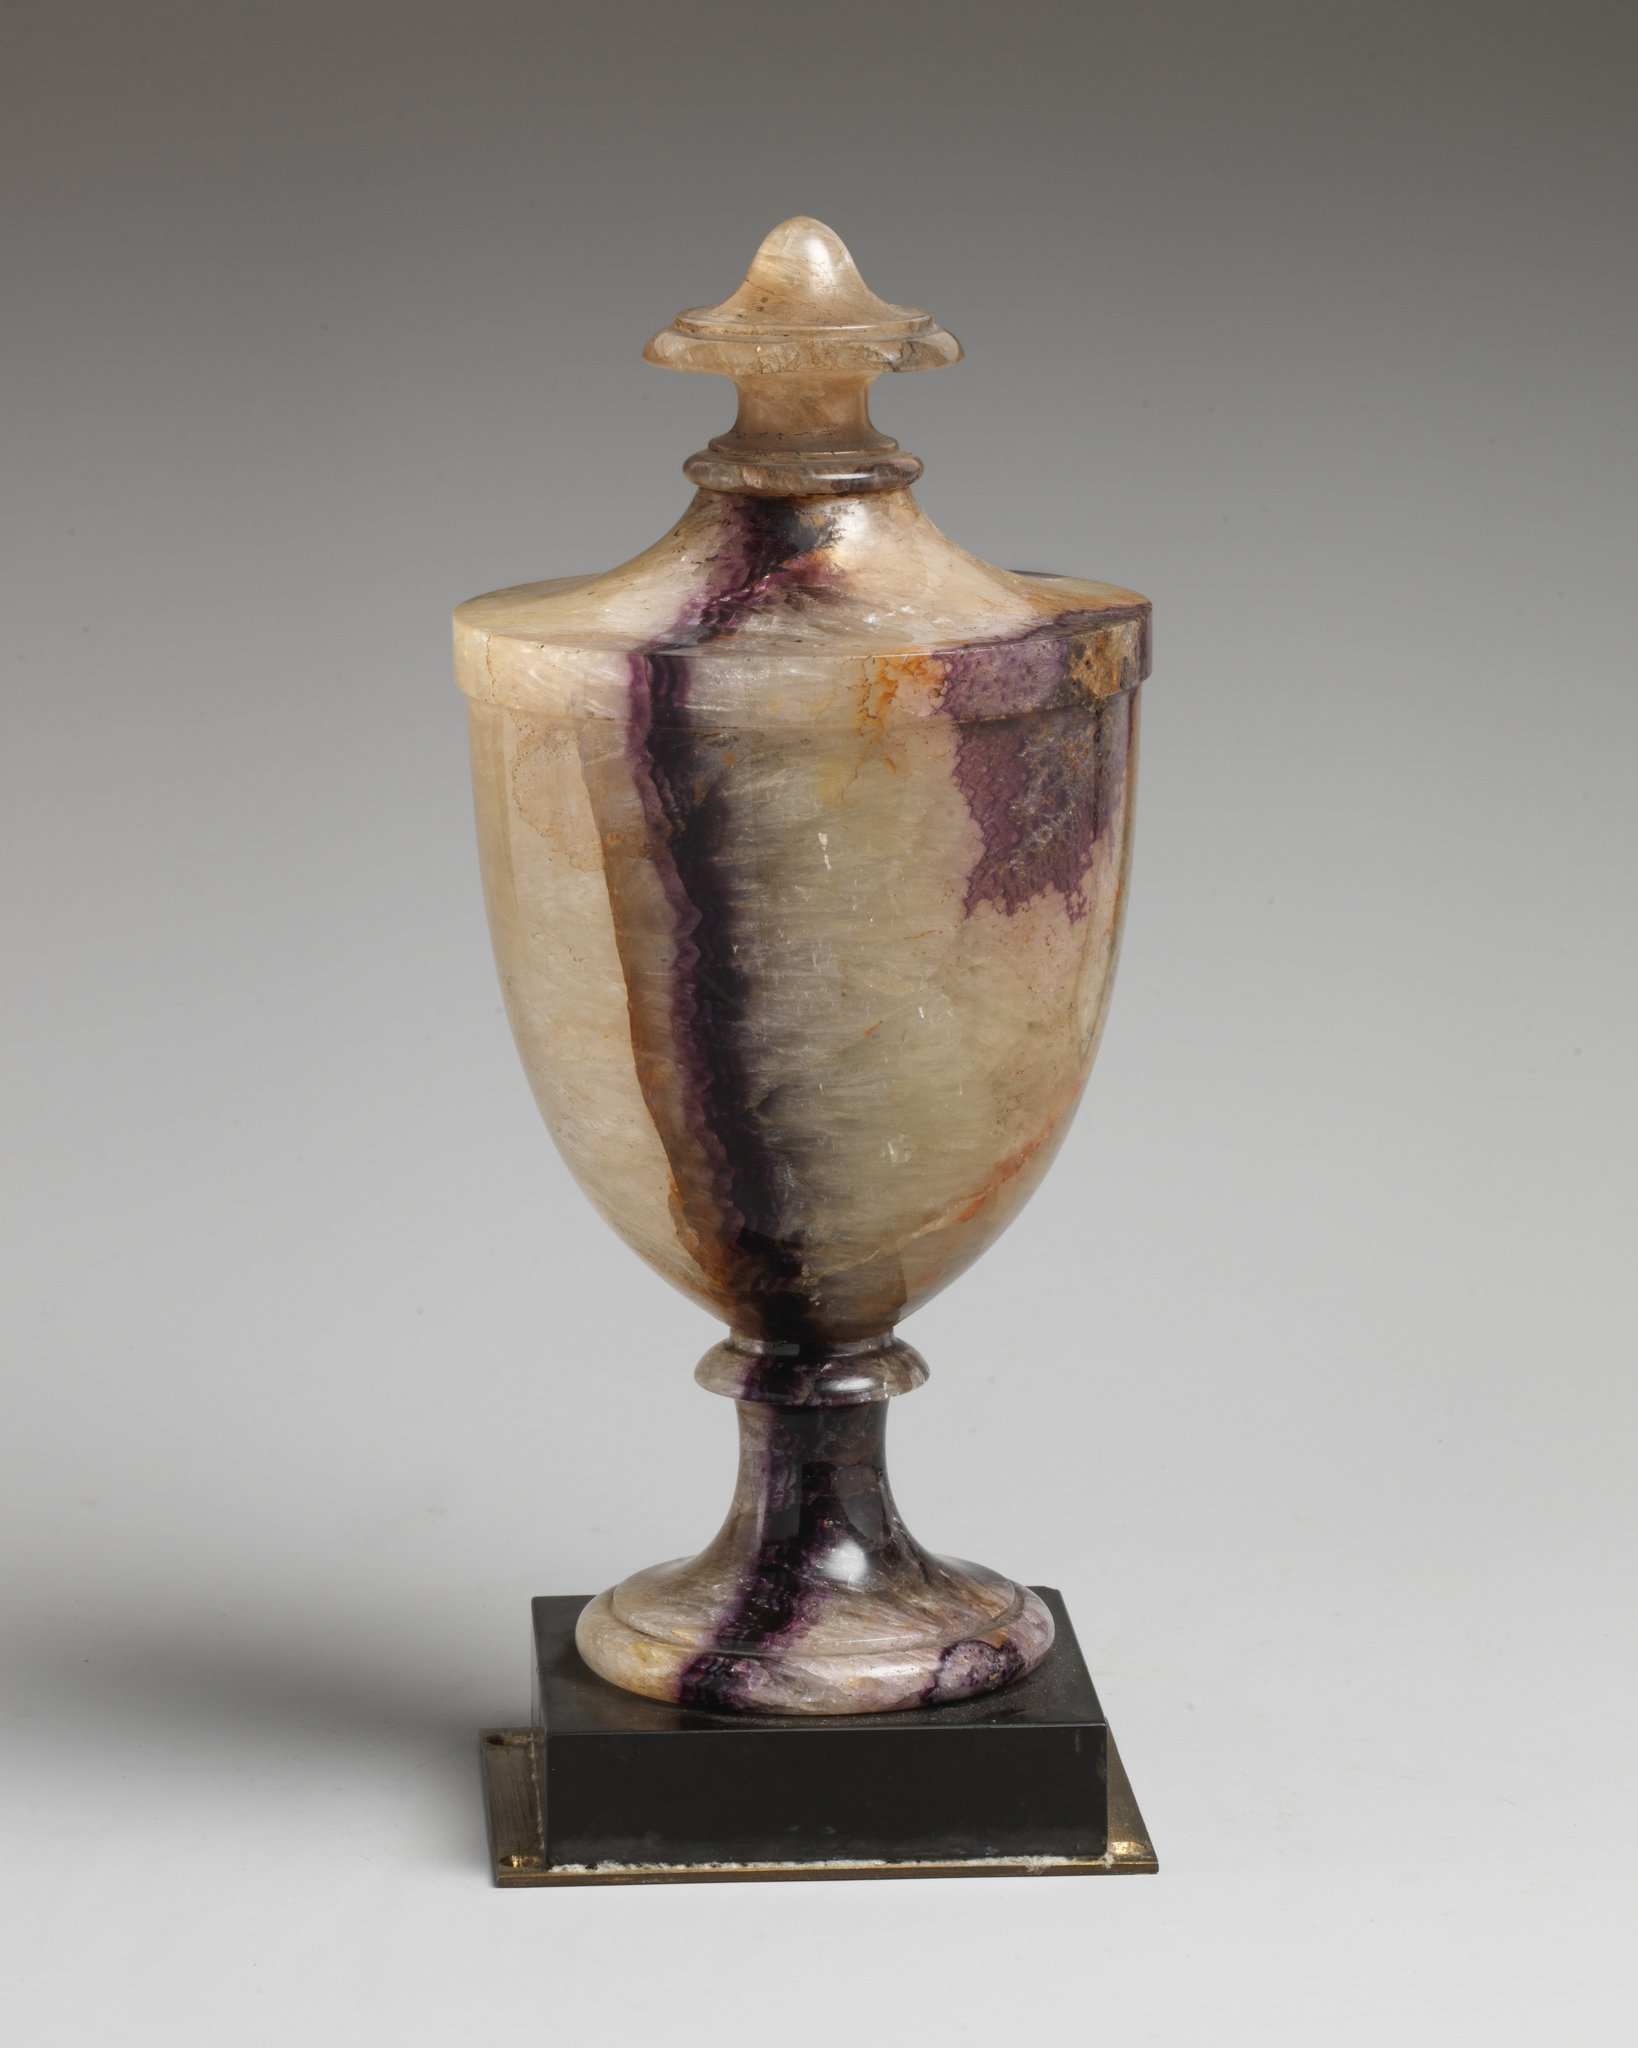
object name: ornament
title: Ornament (one of a pair)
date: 1770-1780